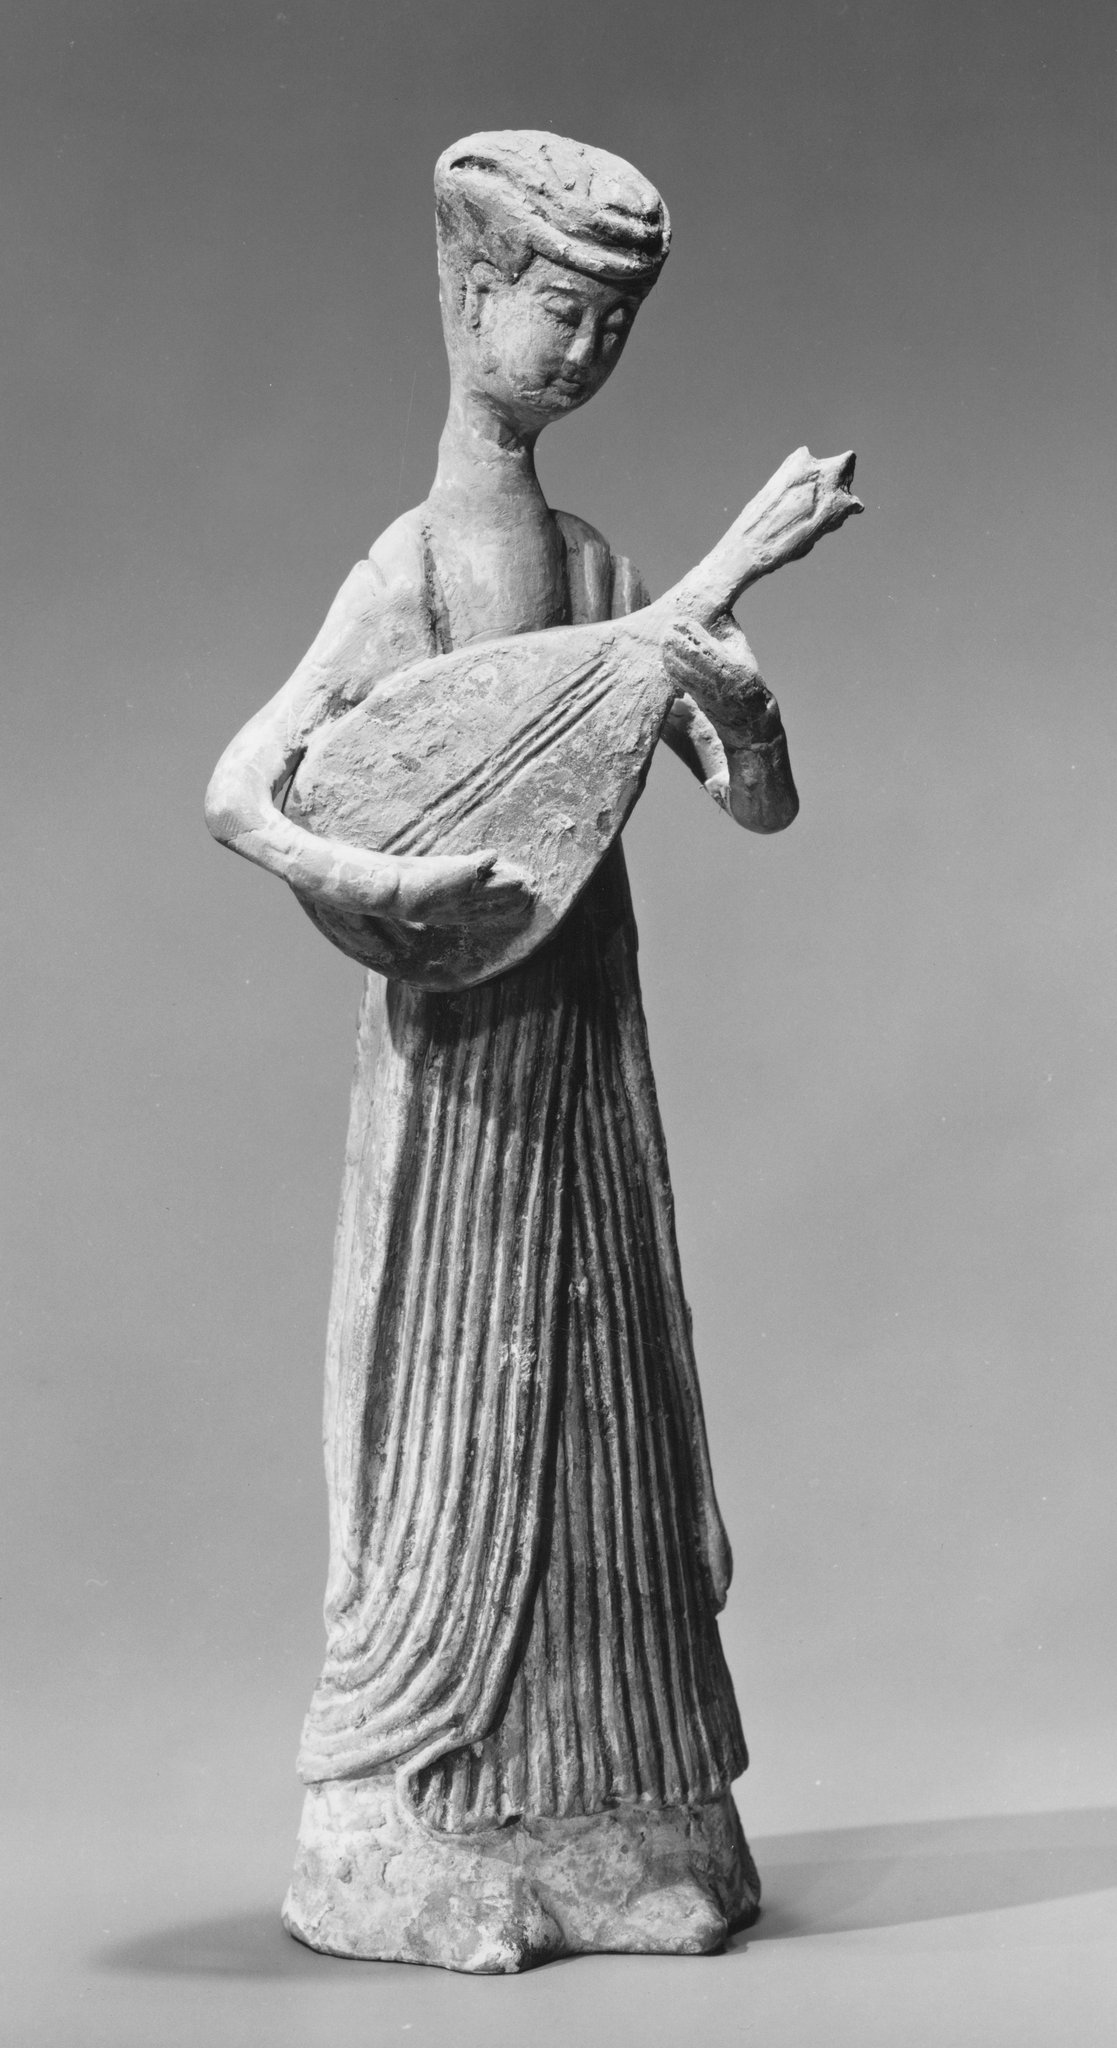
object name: figure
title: Female musician with a lute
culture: chinese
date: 501-600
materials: earthenware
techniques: polychrome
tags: lutes